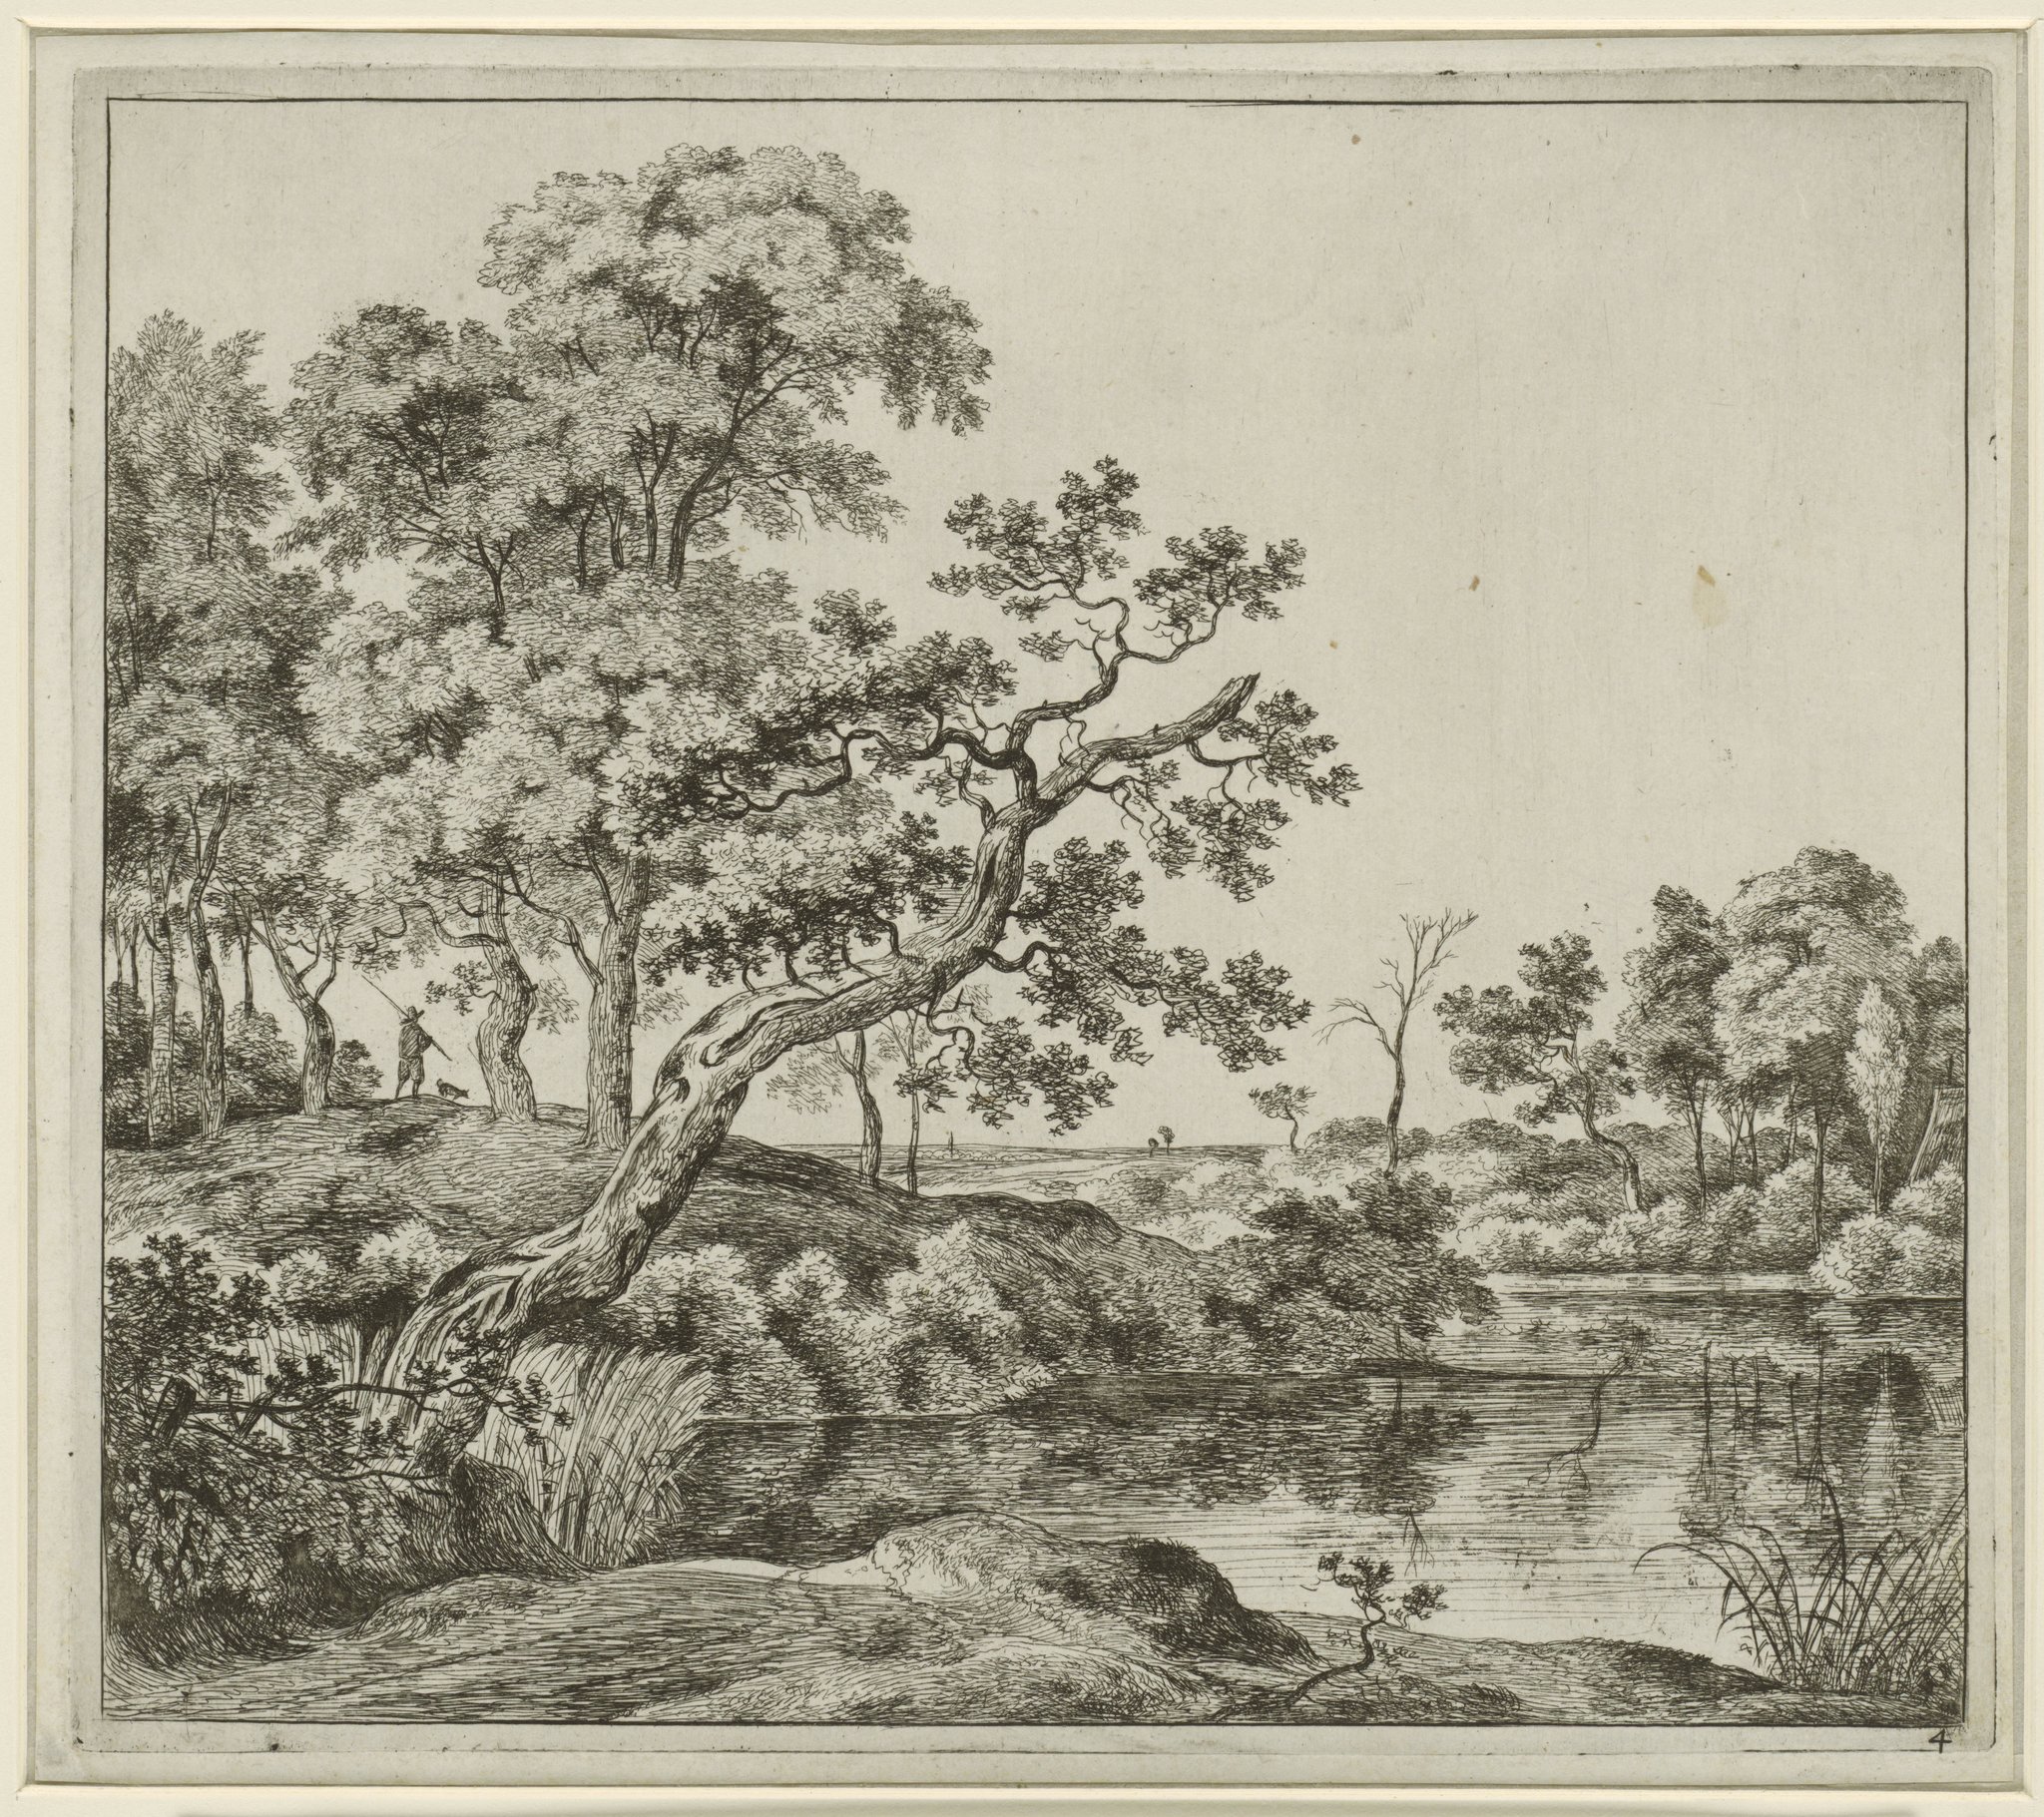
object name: print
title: Landschappen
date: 1640-1699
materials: paper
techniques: etching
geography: amsterdam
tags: trees, river bank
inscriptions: collector's mark: Lugt 240